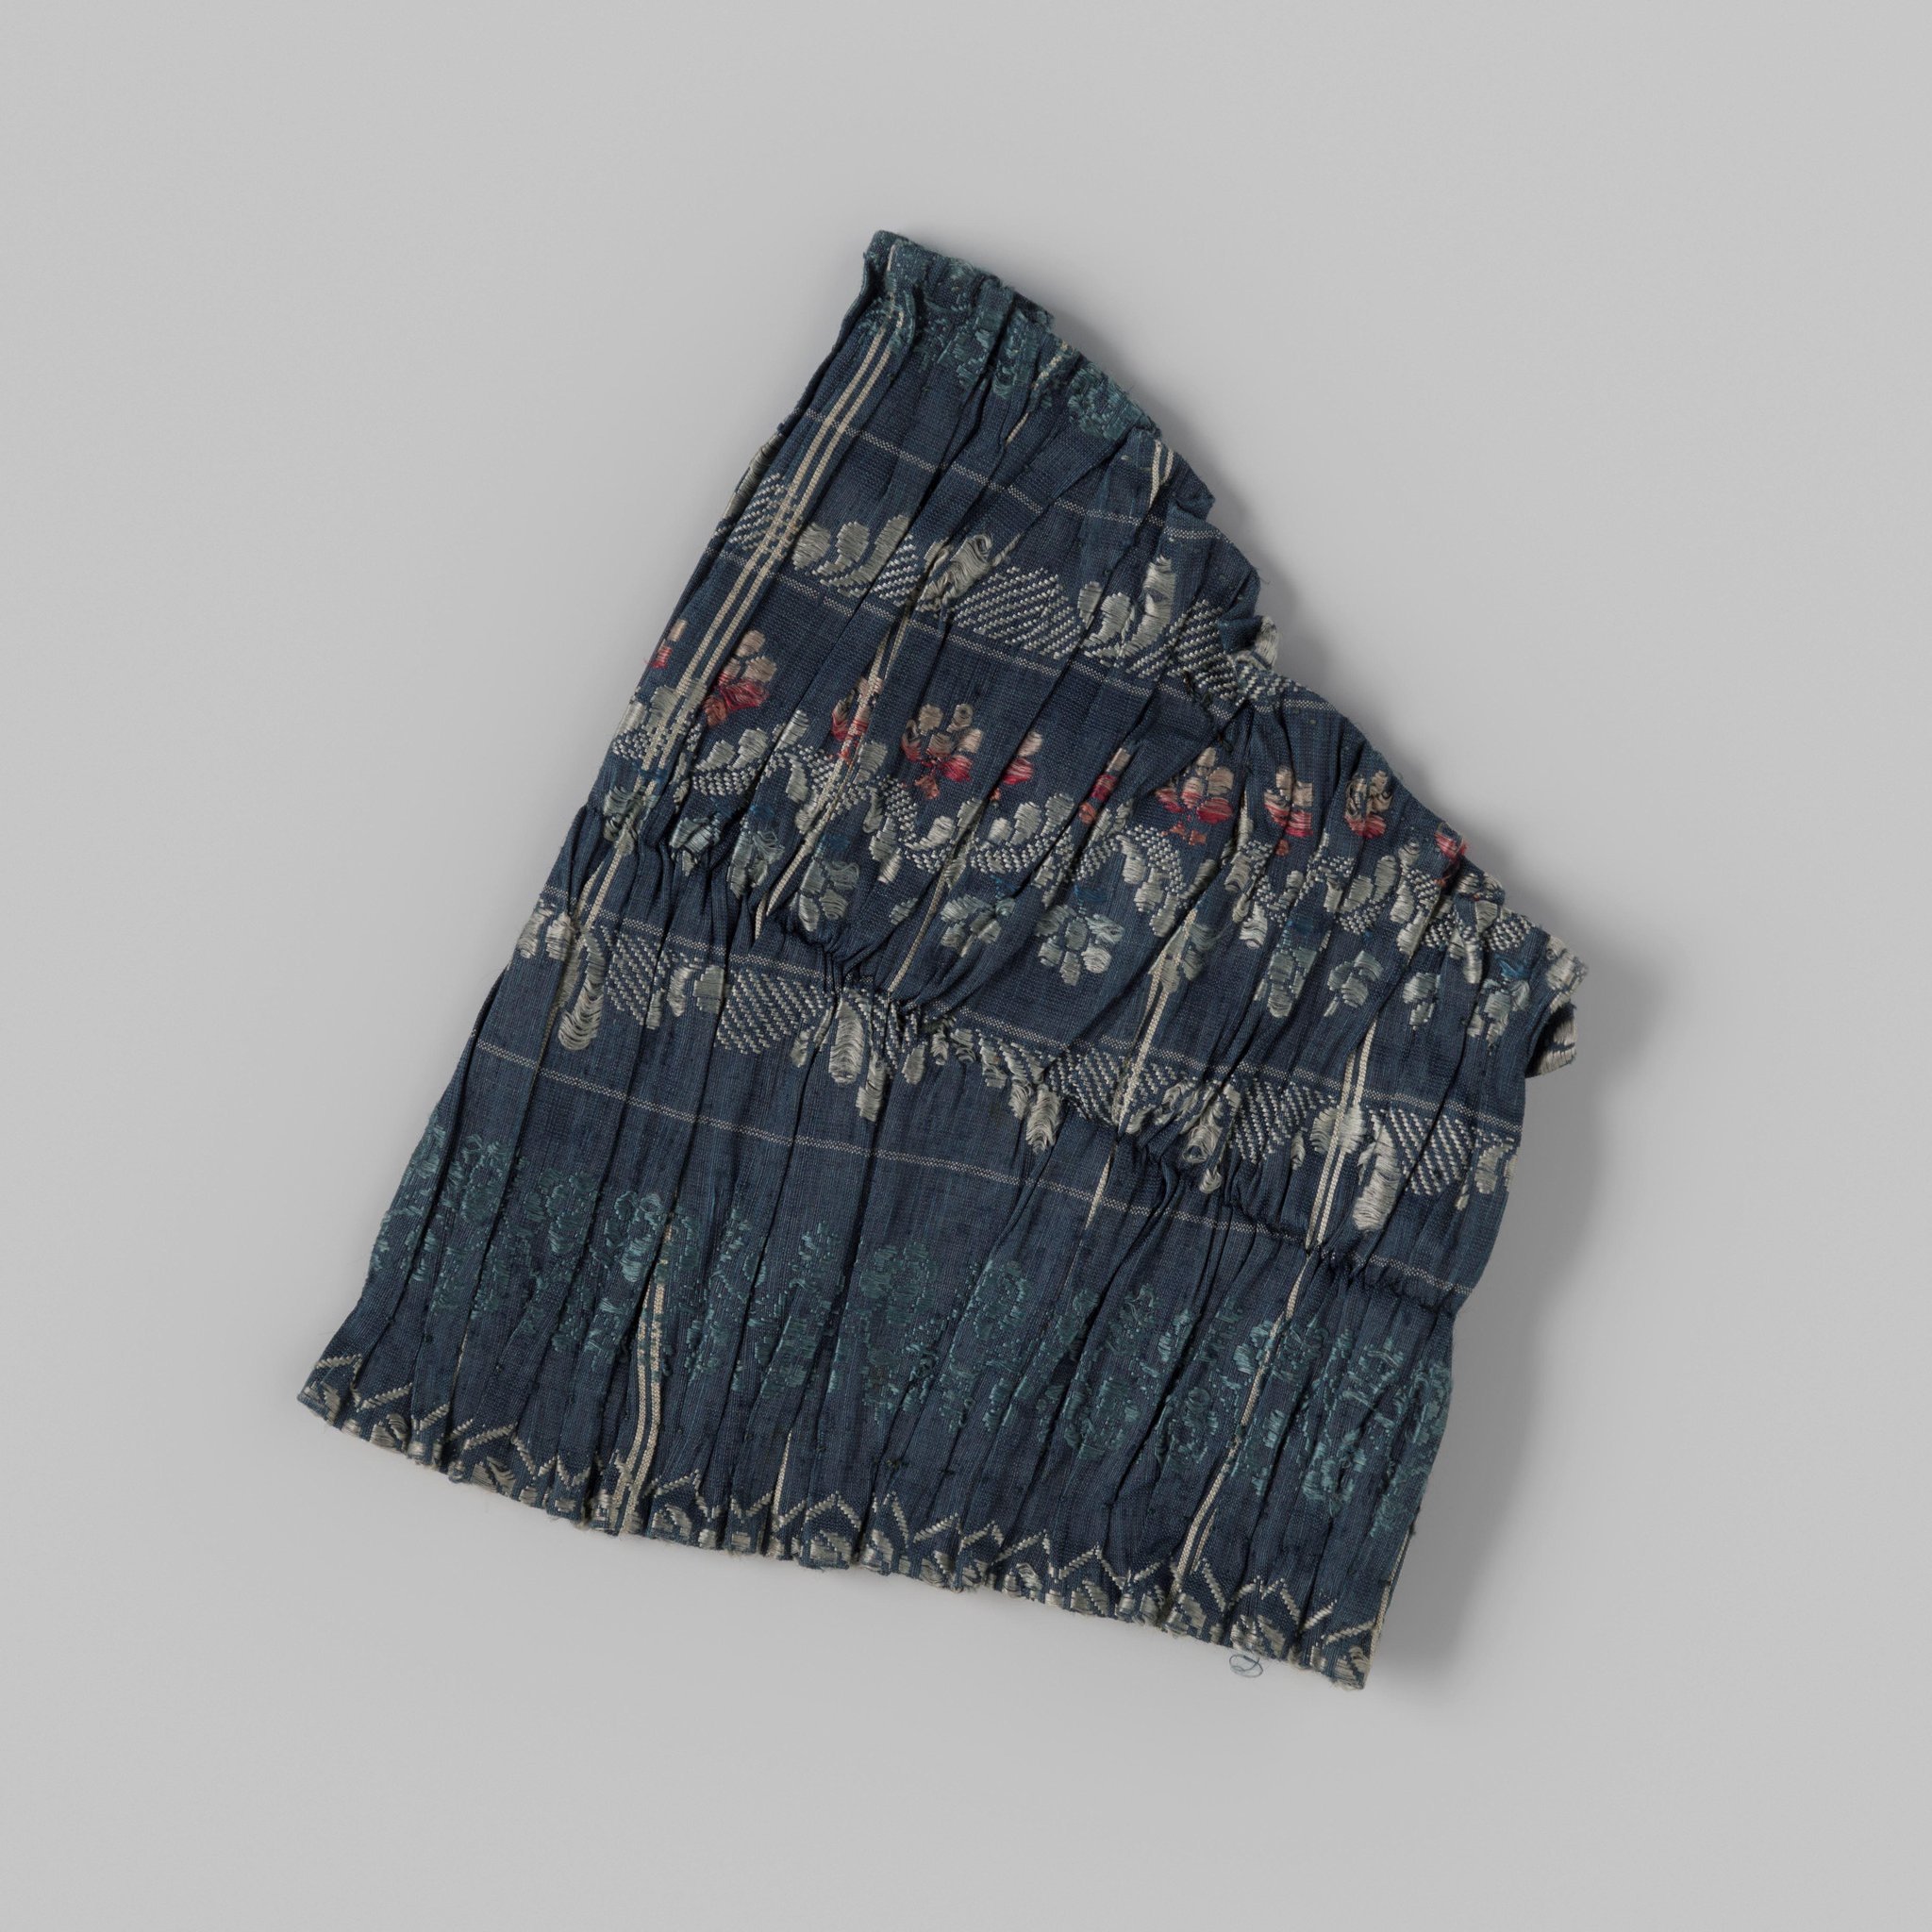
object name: engageante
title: Engageante van een robe à l'Anglaise van blauwe zijde met ruit- en bloemmotief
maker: Anonymous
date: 1760-1775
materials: linen, silk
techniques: embroidered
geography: western europe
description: Engageante, geplooid, van een robe à l'Anglaise van blauwe zijde met ingeweven ruitmotief en geborduurd bloemmotief, gevoerd met geruit linnen.